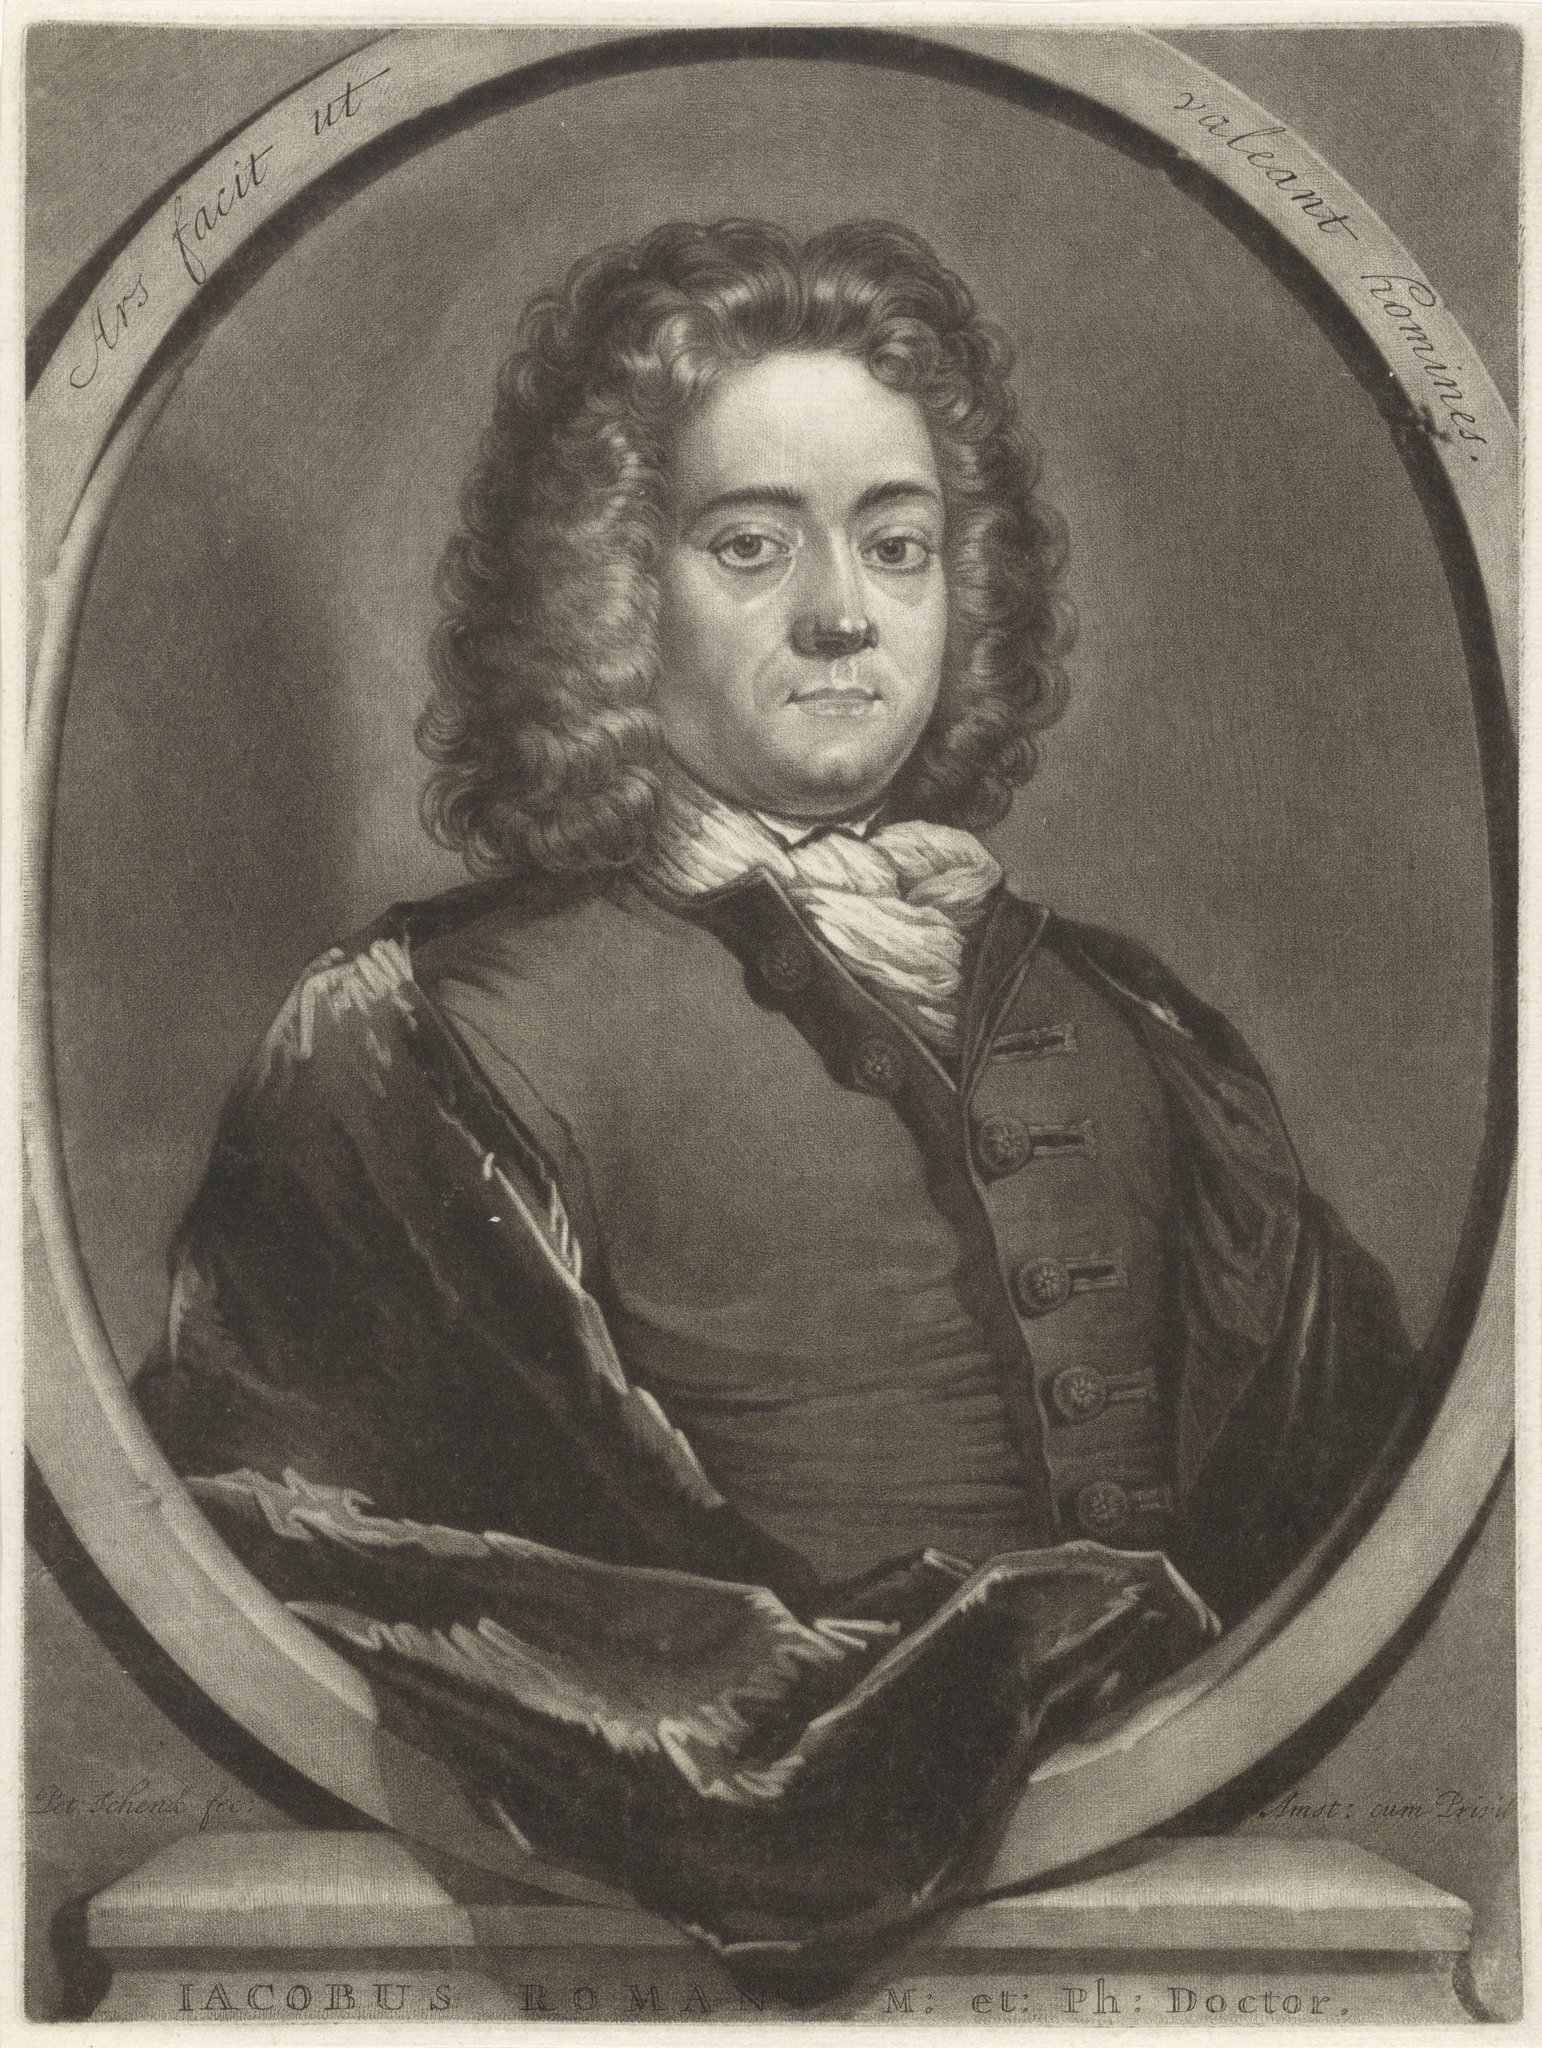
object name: print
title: Portret van de arts Jacob Roman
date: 1670-1713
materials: paper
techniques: engraving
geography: amsterdam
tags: jacob roman